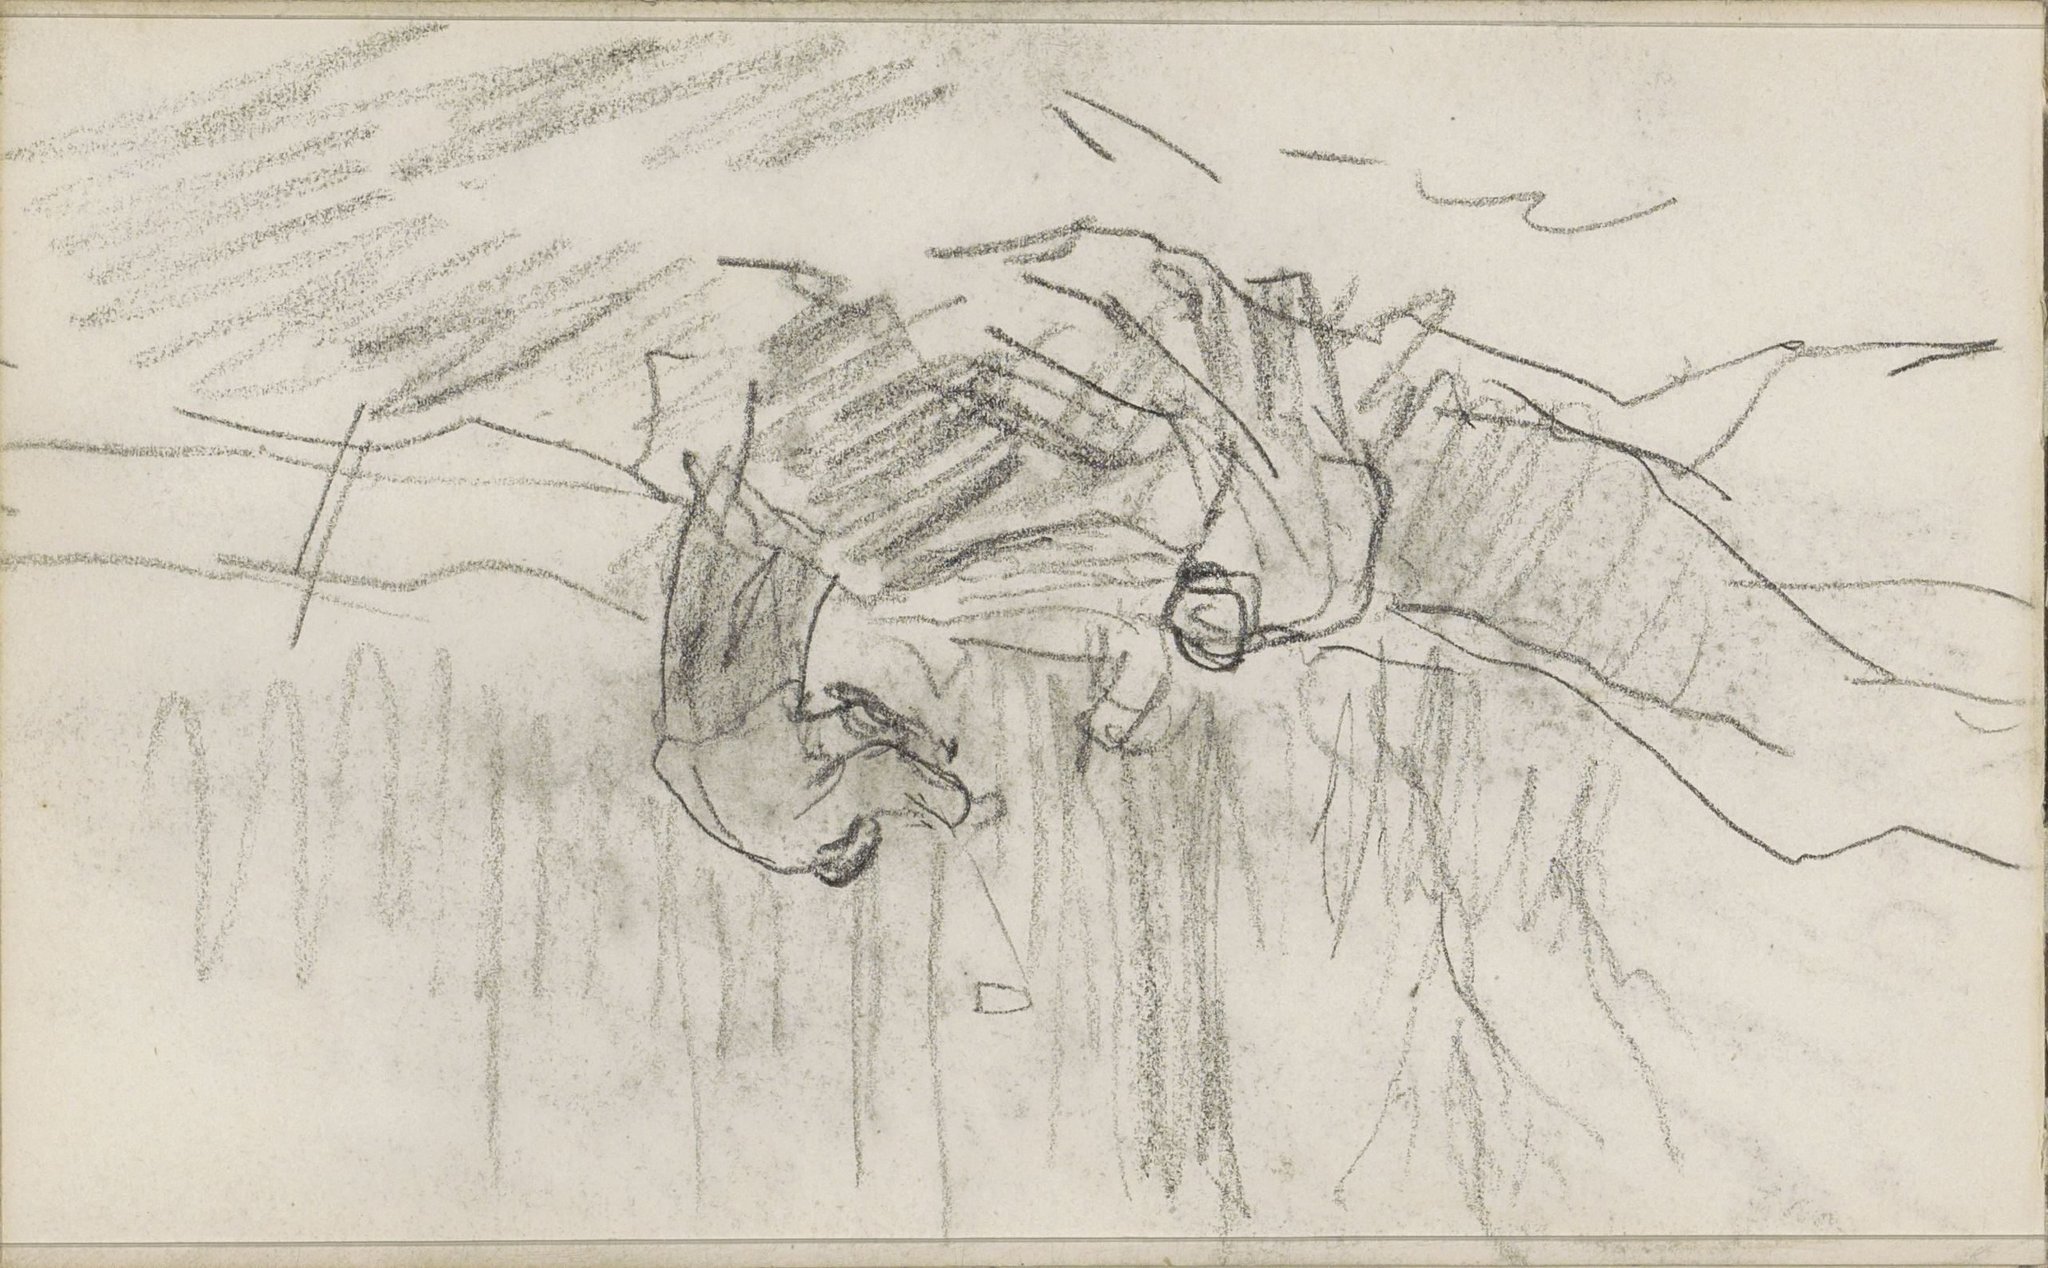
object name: sketchbook leaf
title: Houthakkers bij een omgehakte boom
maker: anton mauve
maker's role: draughtsman, painter, print maker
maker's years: 1838-1888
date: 1848-1888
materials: chalk, paper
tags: woodcutting, woodcutter ~ forestry, trees (+ stem, trunk)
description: Blad 14 verso uit een schetsboek met 41 bladen.